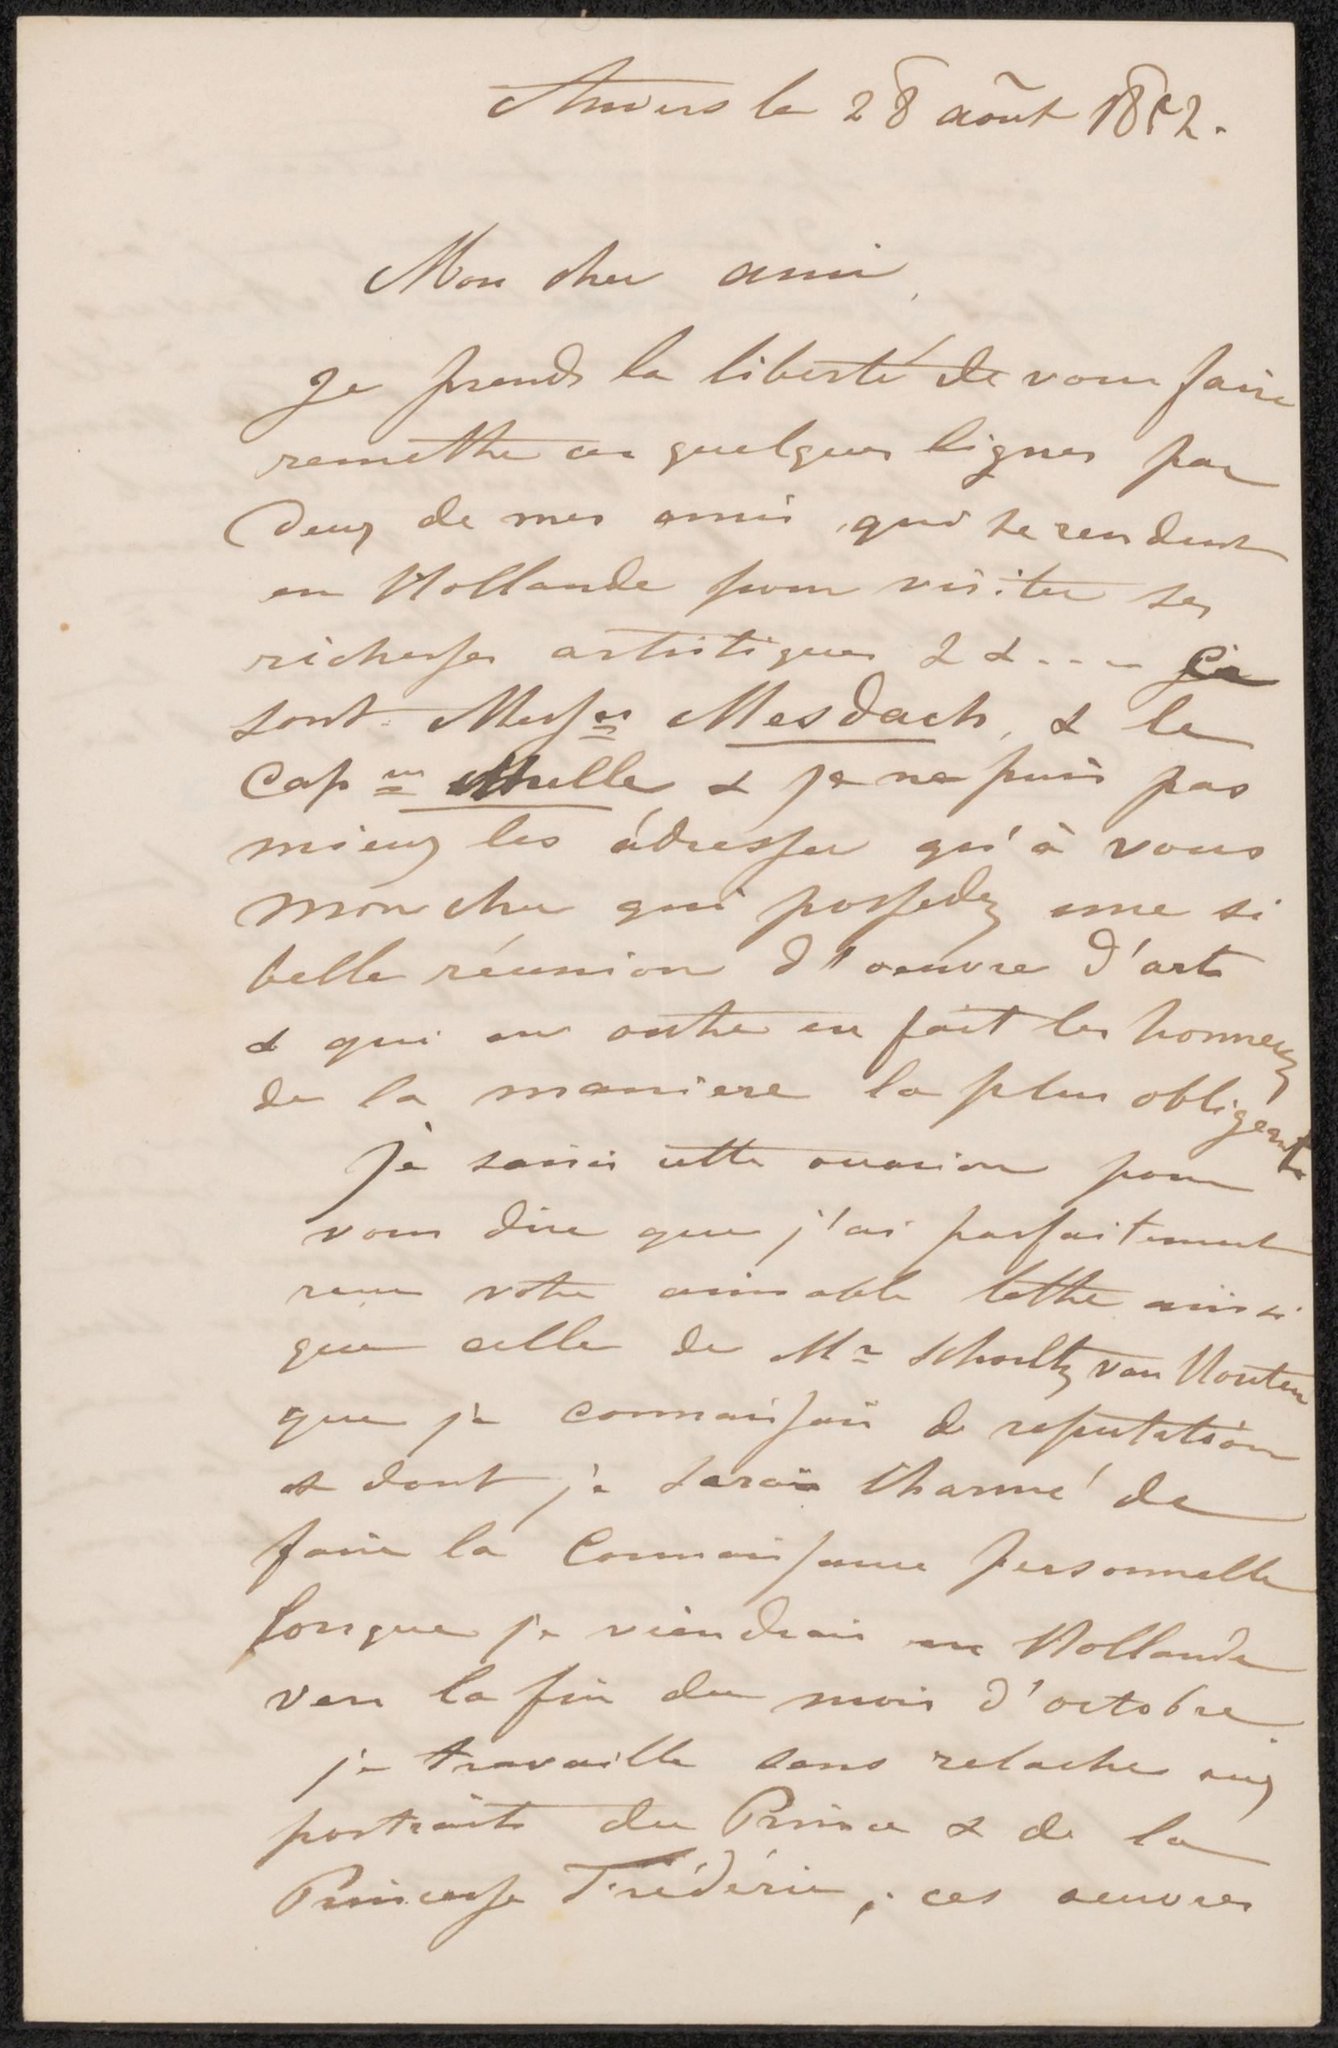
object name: letter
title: Brief aan anoniem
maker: nicaise de keyser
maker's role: draughtsman, painter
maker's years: 1813-1887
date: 1852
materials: ink, paper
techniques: pen, writing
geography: antwerp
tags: painting (including book-illumination, miniature-painting), exhibition ~ art, art collecting, netherlands, antwerp